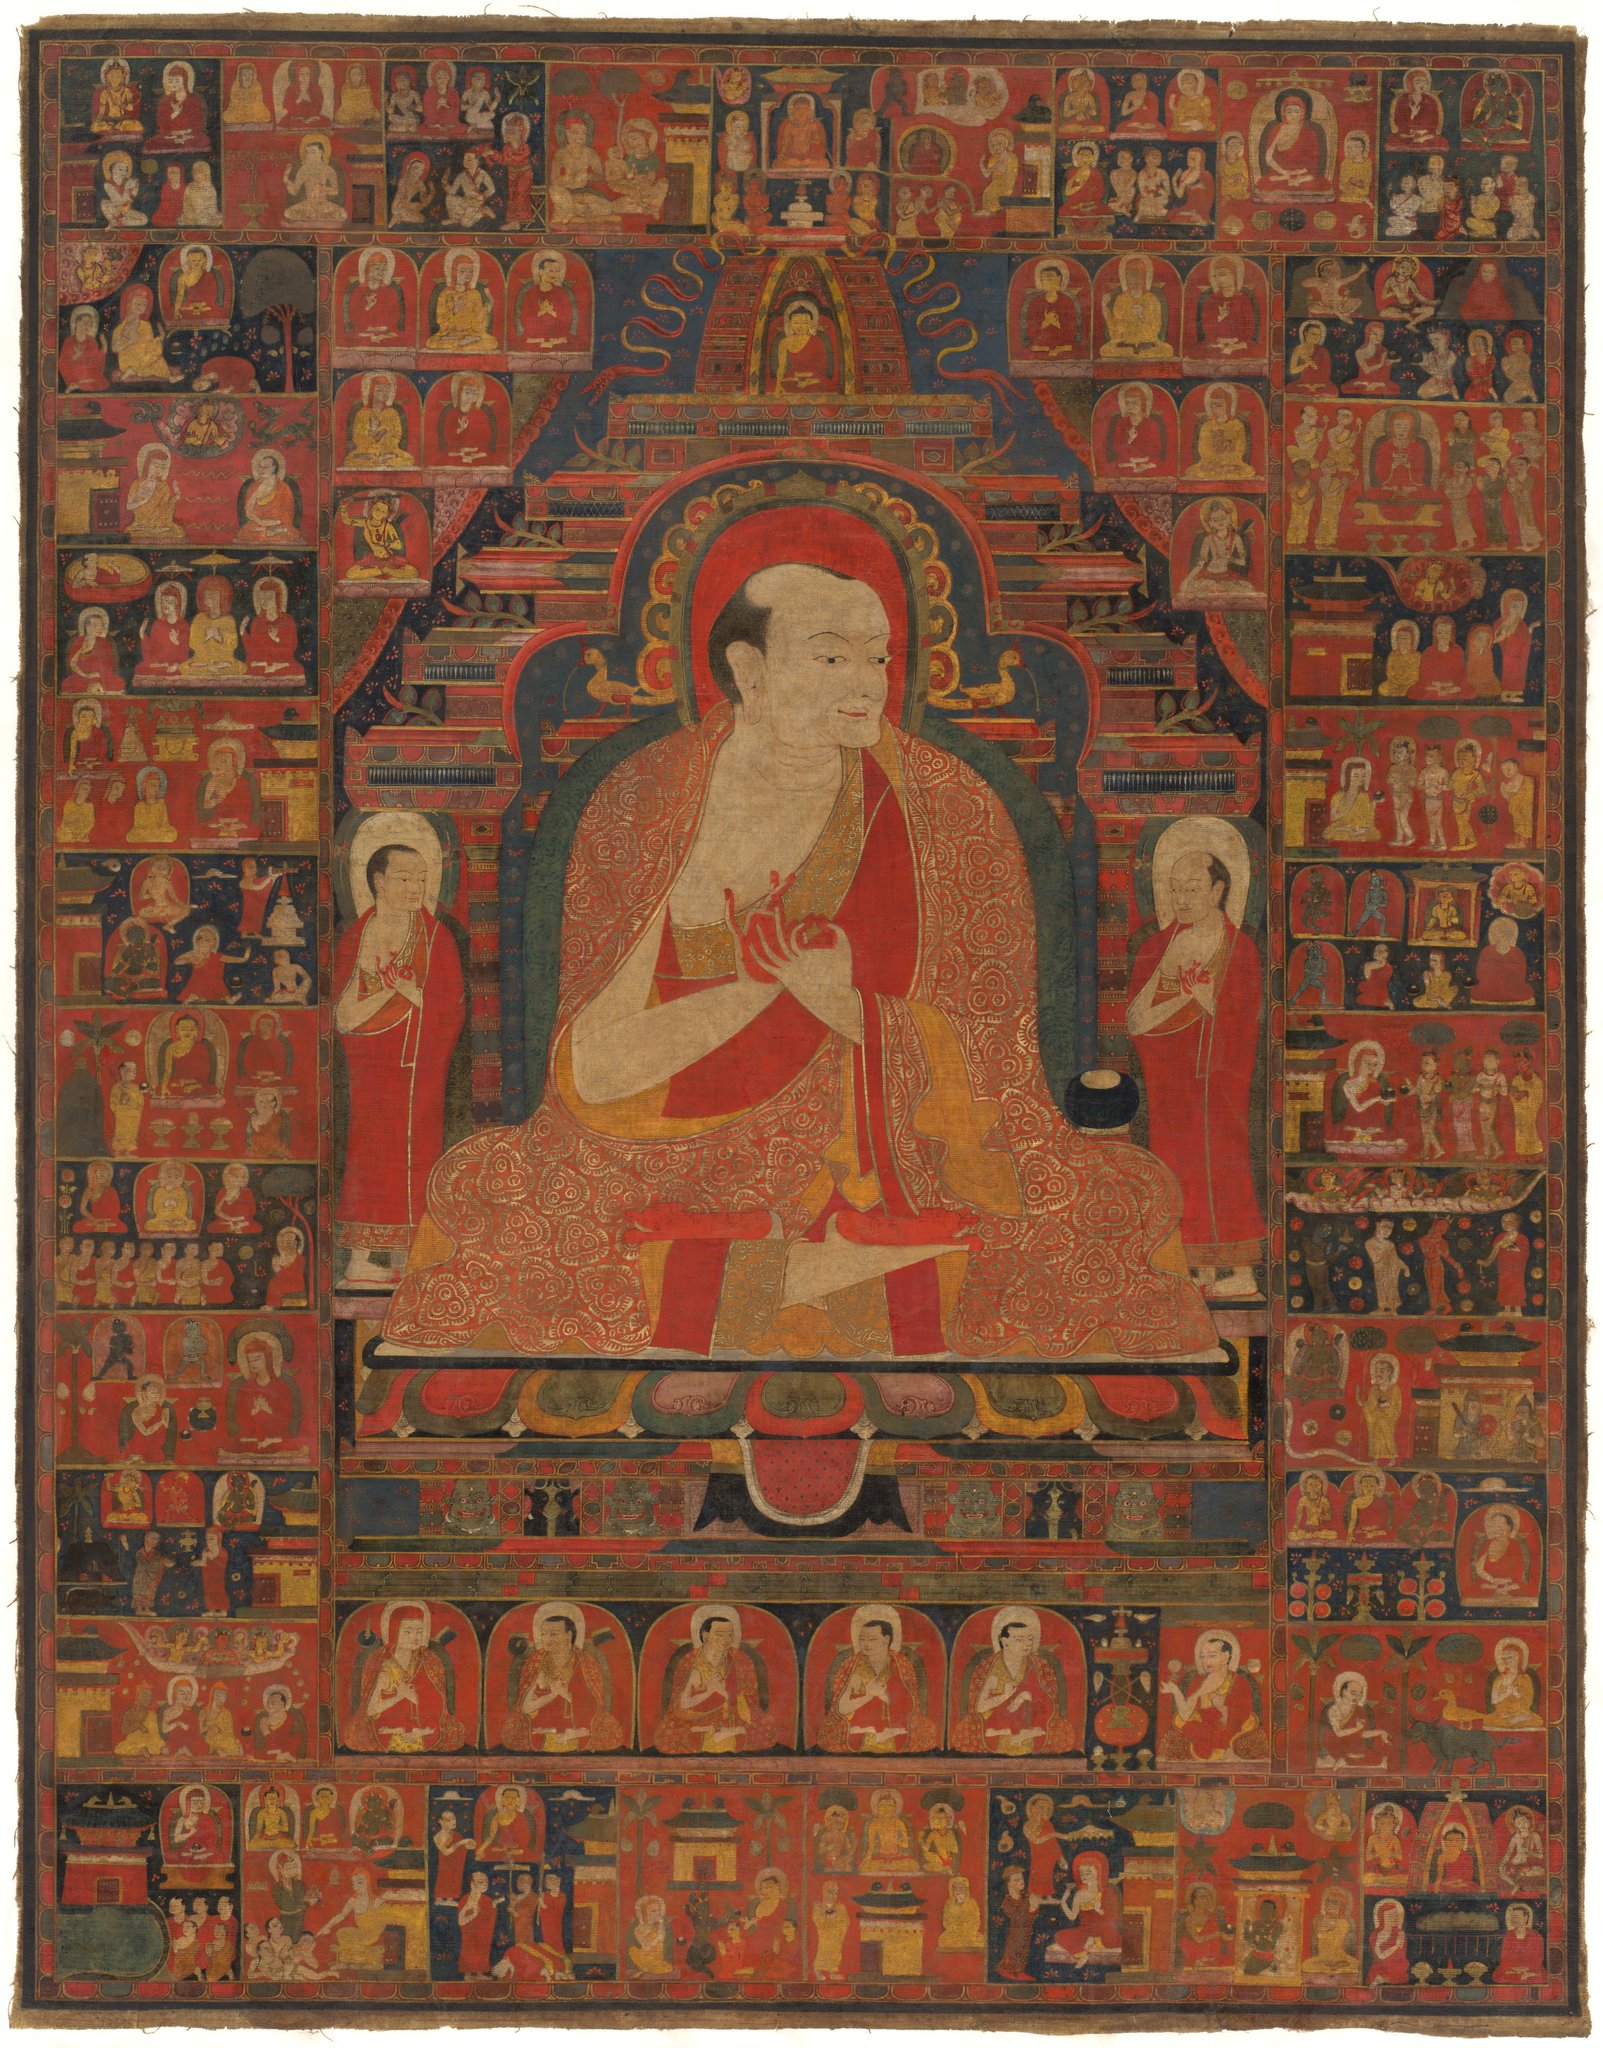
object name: thangka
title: Portrait of Shakyashribhadra with His Life Episodes and Lineage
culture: tibetan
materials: textile